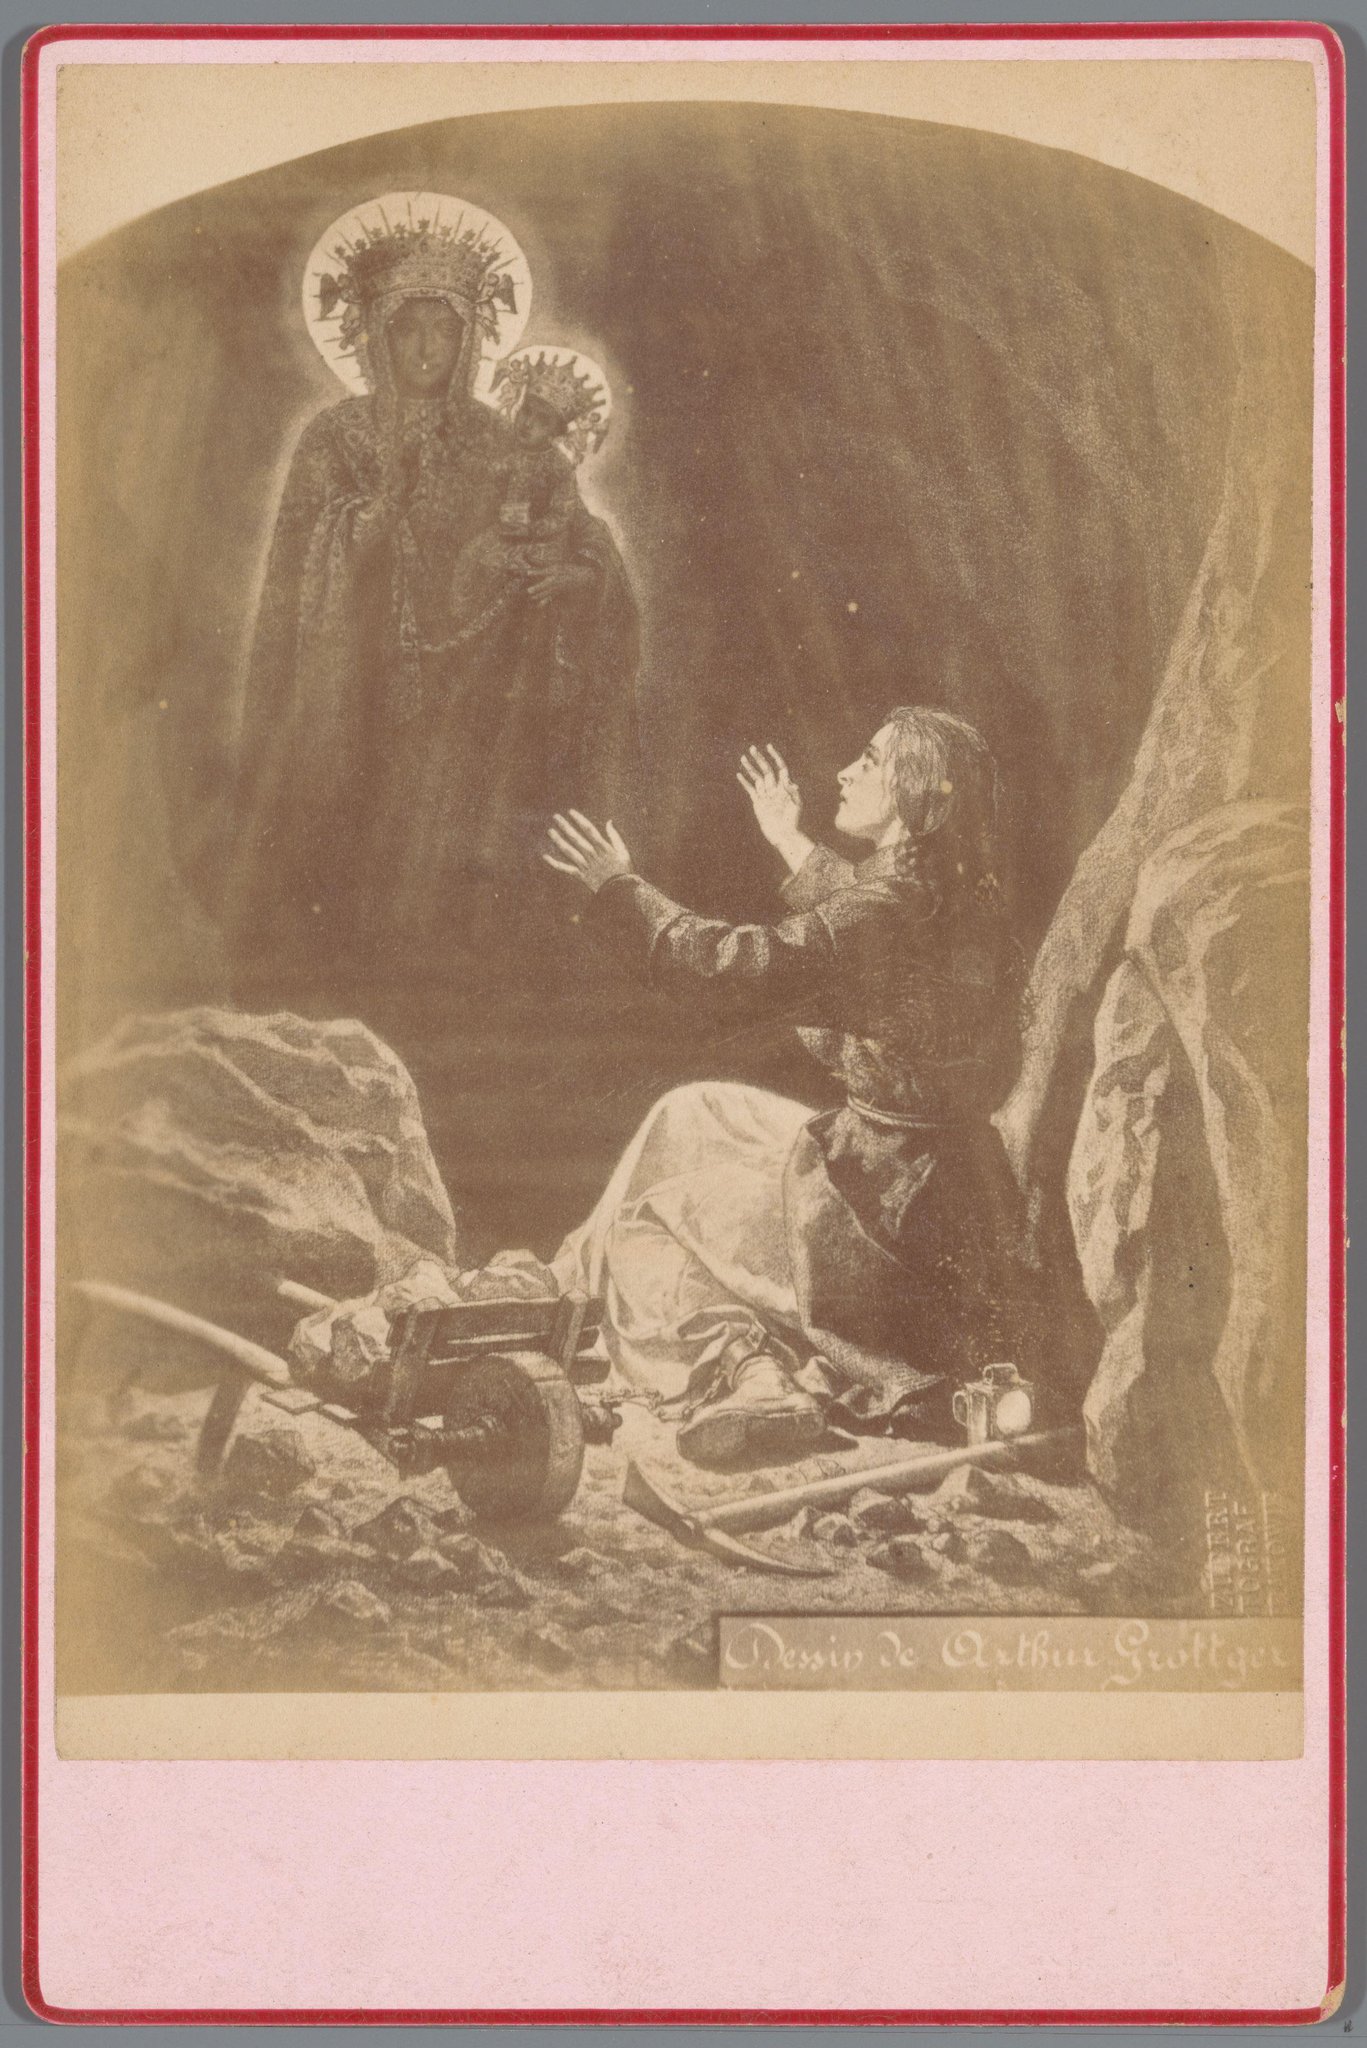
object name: reproduction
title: Fotoreproductie van de tekening door Arthur Grottger uit de serie Litouwen, voorstellende een mens met een visioen in een mijn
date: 1870-1890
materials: cardboard, photographic support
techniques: albumen print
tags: drawing, sketch, vision in trance or ecstasy, mine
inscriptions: name: ‘[...]Zufert [...]tograf [...]Krakowie’, name: ‘Vosmaer’